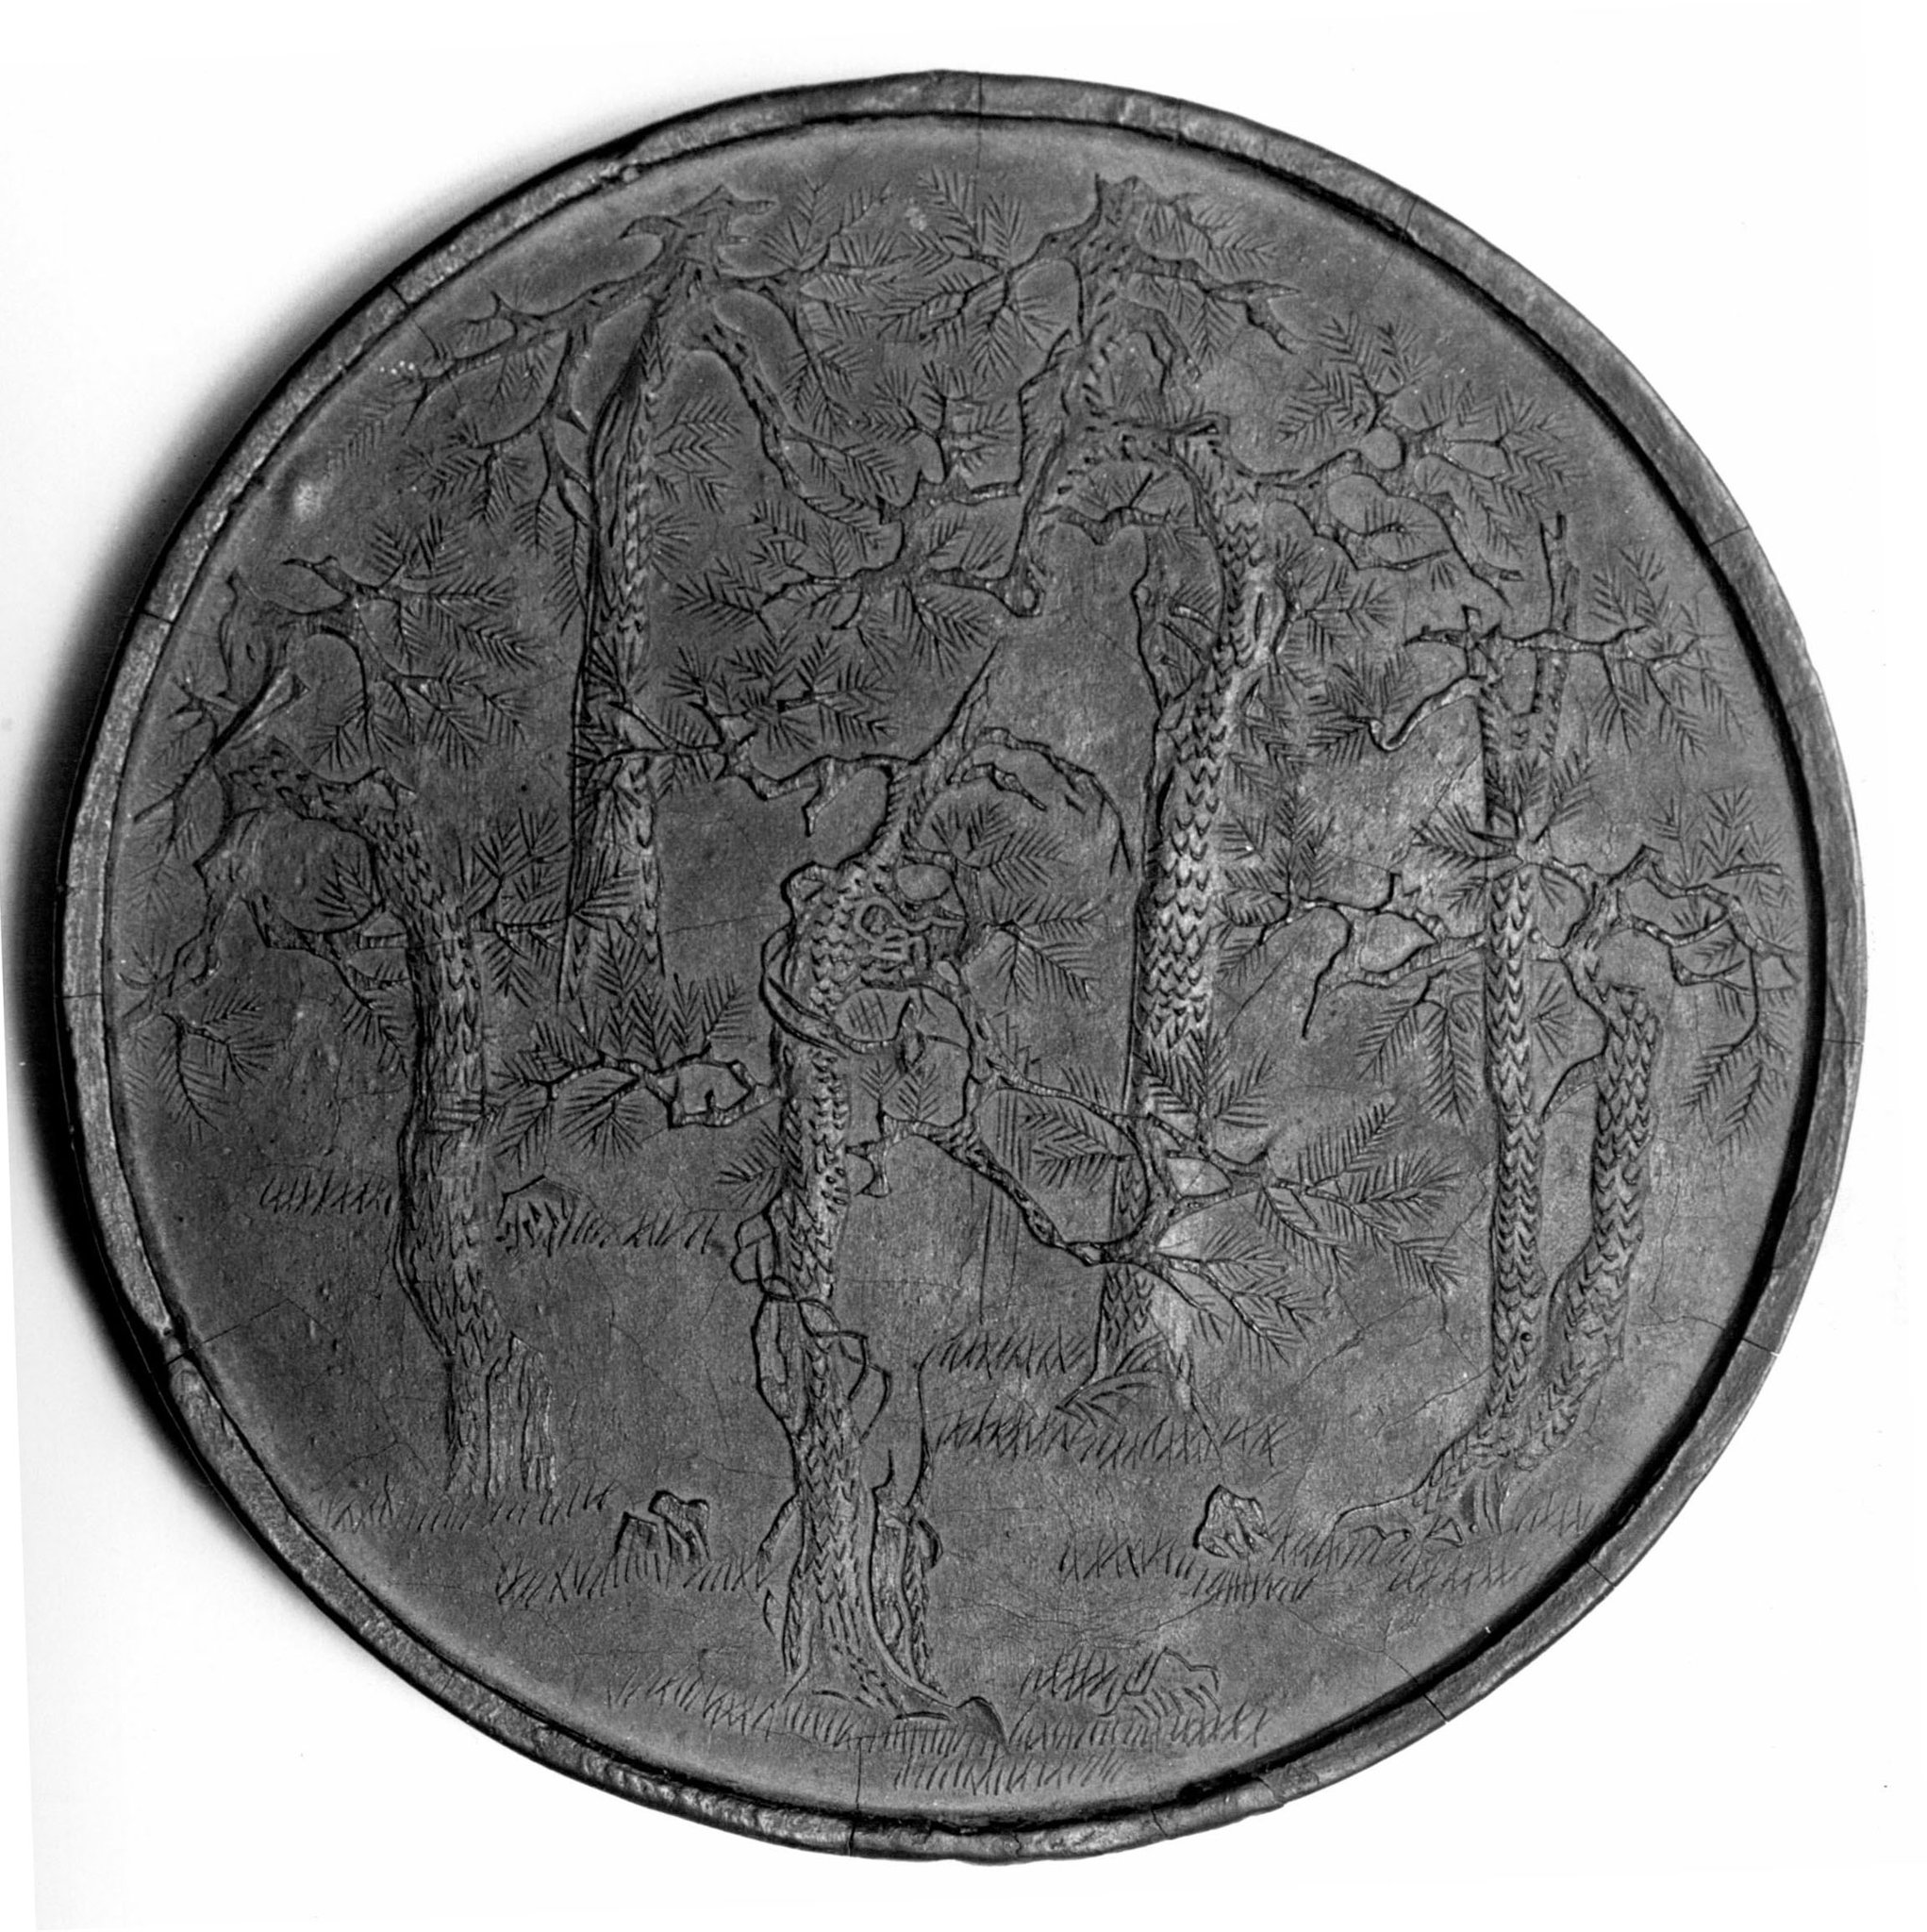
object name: ink tablet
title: Ink Tablet Decorated with Five Pines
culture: chinese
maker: cheng junfang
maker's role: artist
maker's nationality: chinese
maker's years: 1541-1620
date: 1867-1933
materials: ink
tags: trees